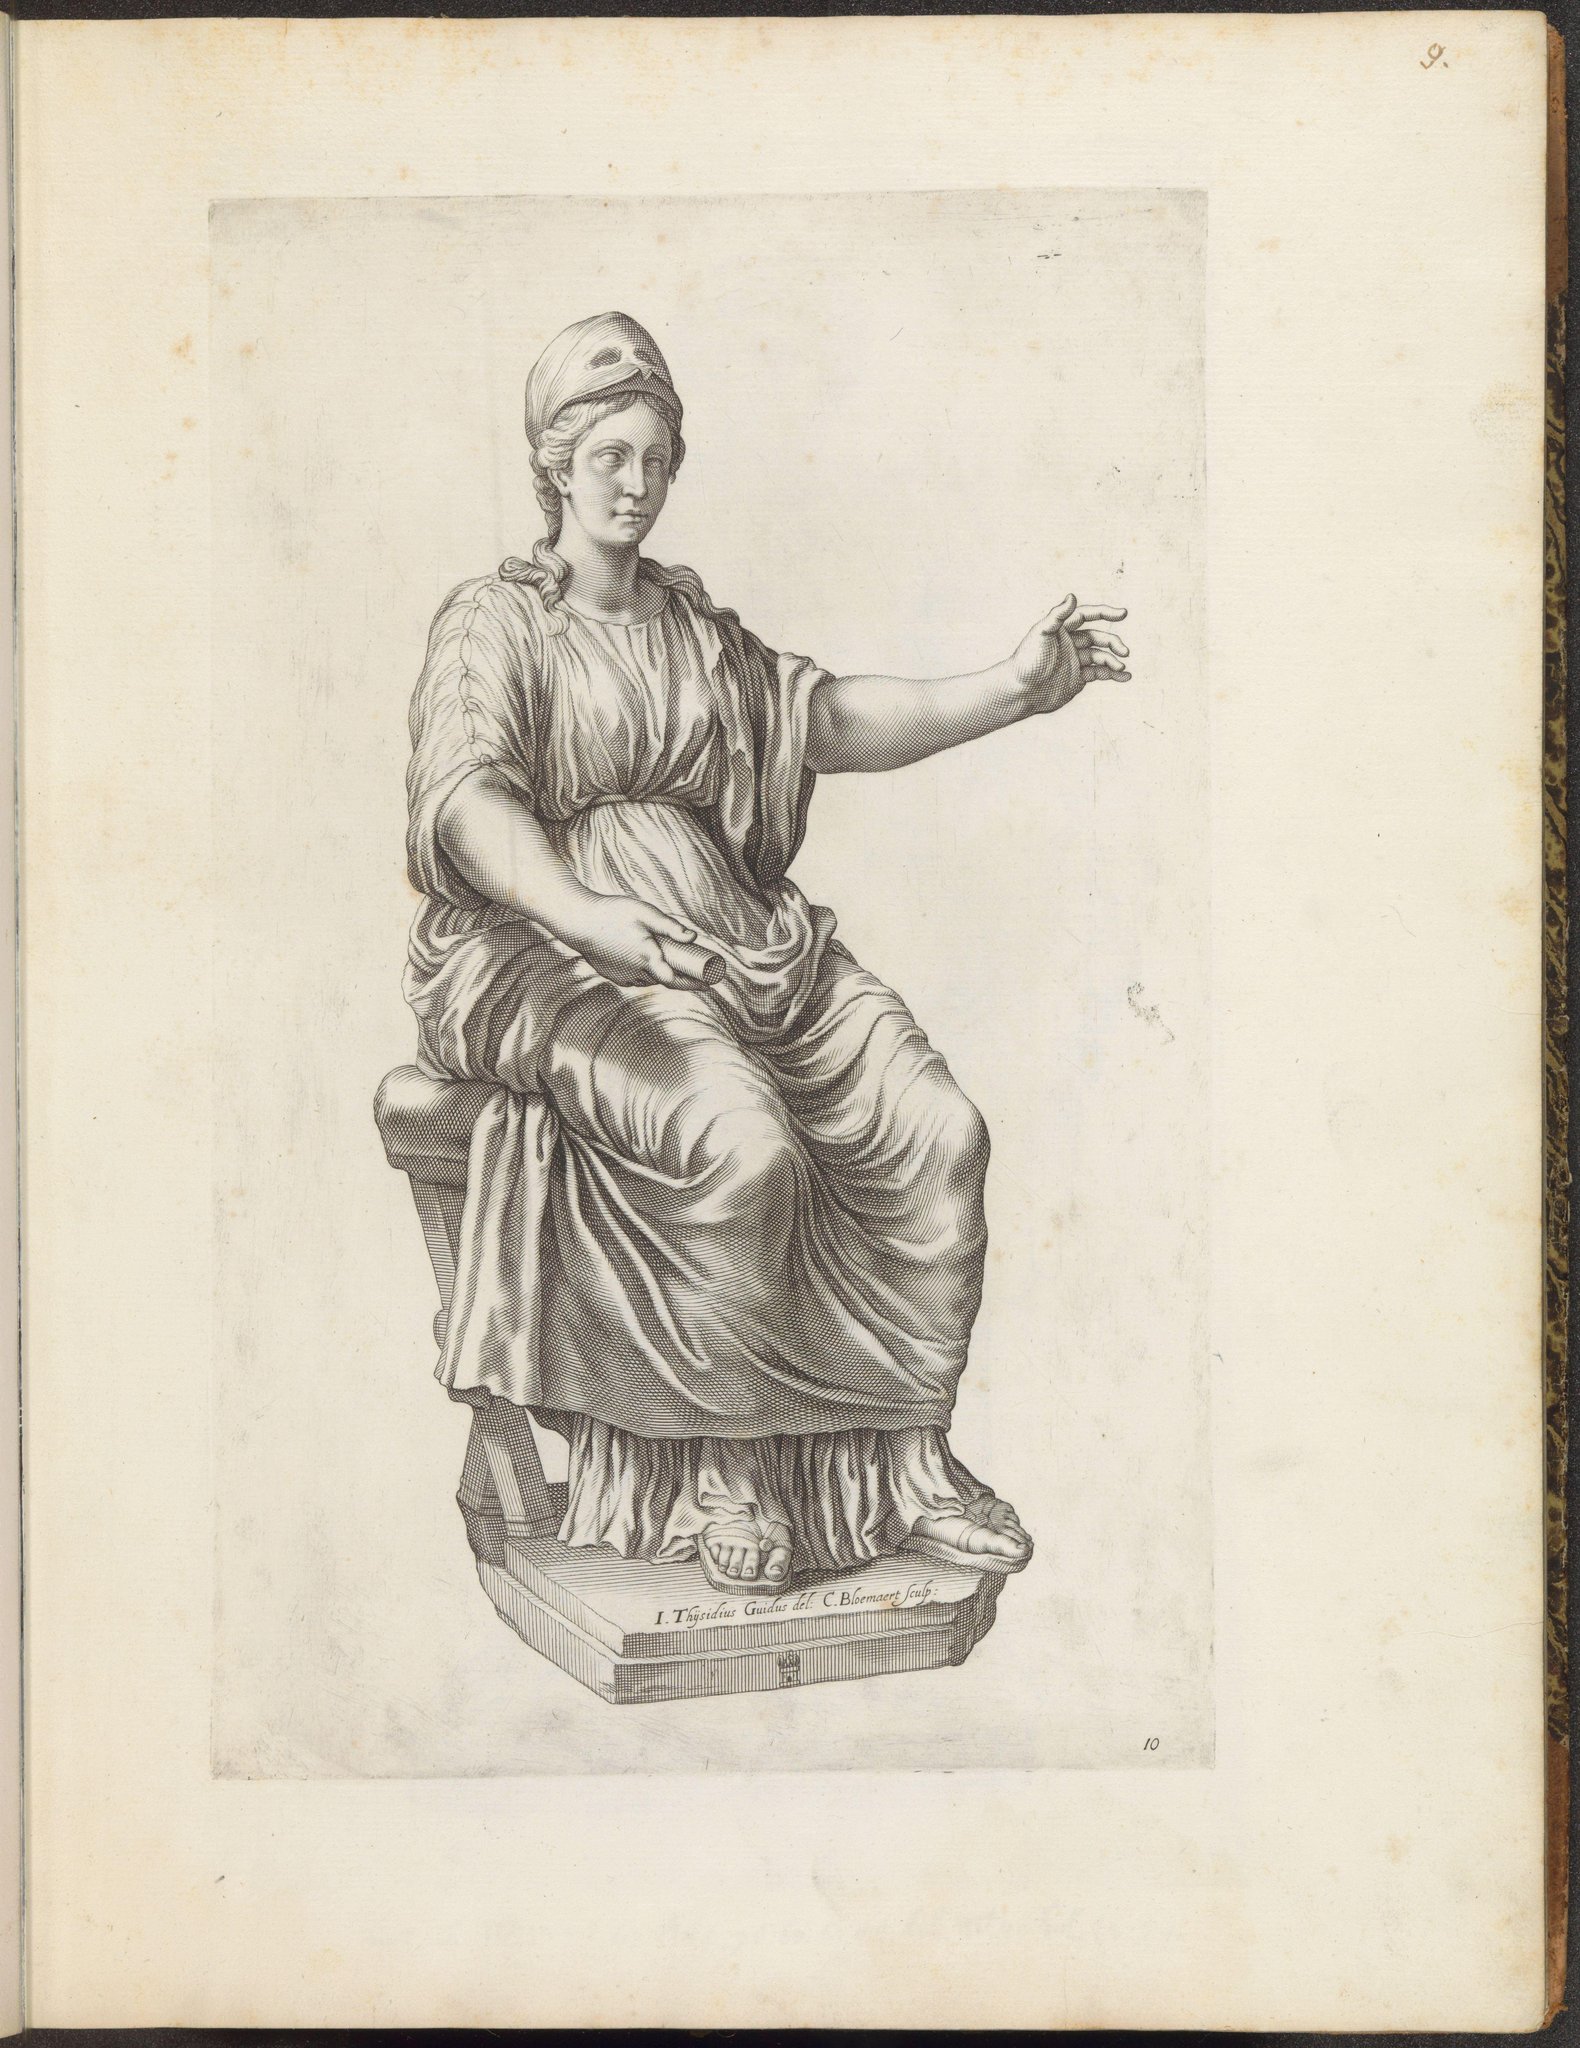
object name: album leaf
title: Standbeeld van de godin Roma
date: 1636-1647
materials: paper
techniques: engraving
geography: rome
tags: personification of a city, town-patron(ess), piece of sculpture, reproduction of a piece of sculpture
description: Beeld van de godin Roma, personificatie van de stad Rome. Op haar hoofd draagt zij een helm, in haar hand houdt ze een stok. Op de basis het wapenschild van Vincenzo Giustiniani. Prent maakt deel uit van een album met een serie prenten naar de sculpturen in de verzameling in de Galleria Giustiniani te Rome.